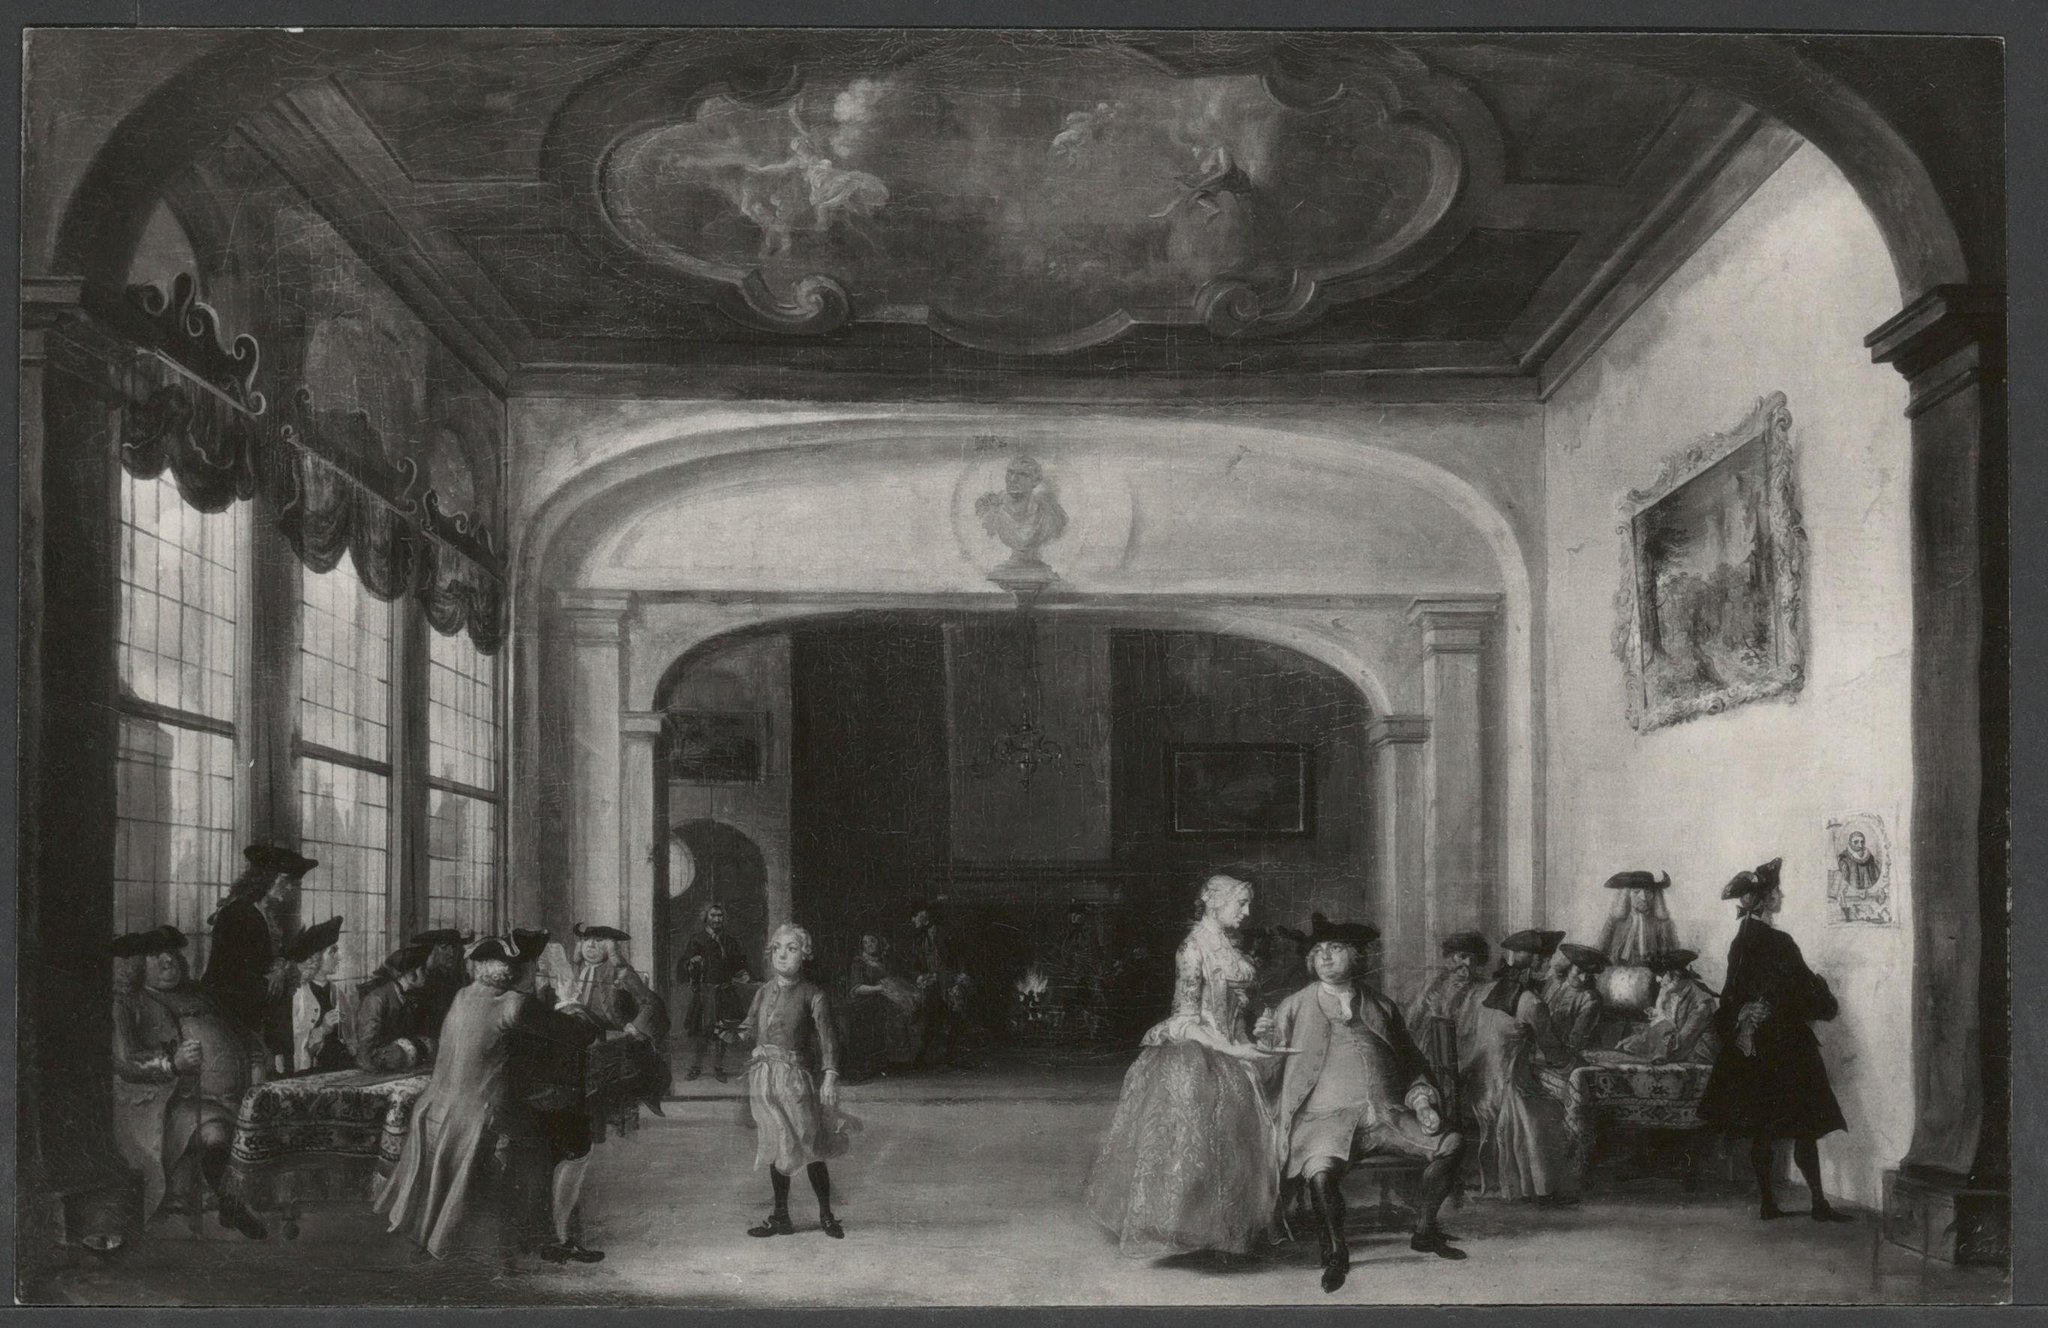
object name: photograph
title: Scène in een restaurant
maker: Anonymous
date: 1900-1999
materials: photographic support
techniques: gelatin silver print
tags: restaurant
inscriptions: collector's mark: Lugt 1641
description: Foto van het schilderij Het restaurant van Cornelis Troost uit de Hermitage te Petersburg. Onderwerpsrubrieken binnen de Atlas Zeden en Gewoonten: Zeden en gewoonten in engeren zin, Volksleven, Uitspanningslokalen, Herberg.